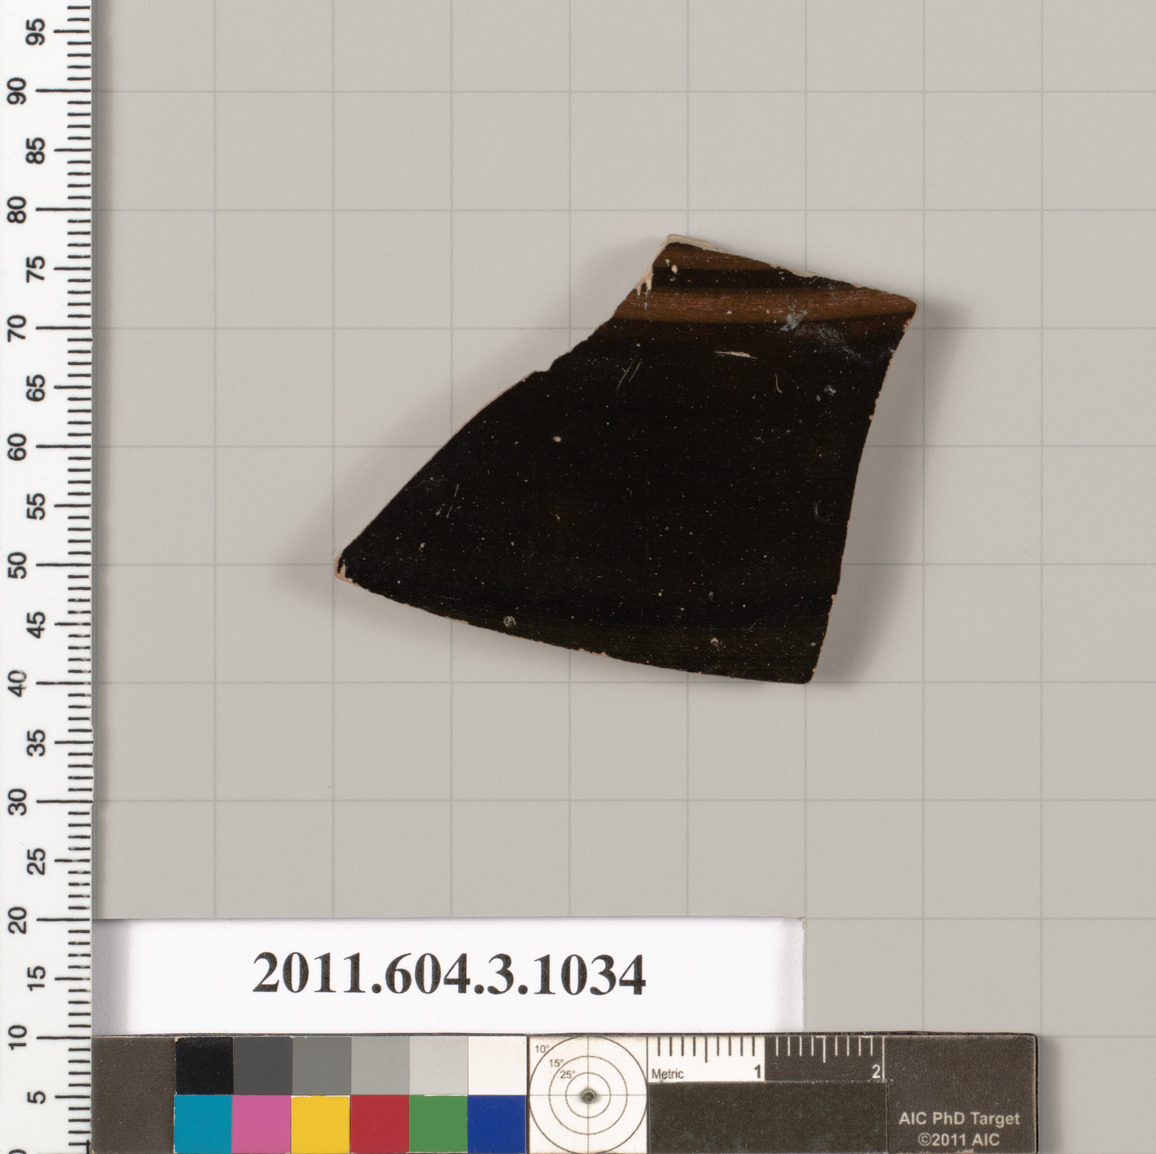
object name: lekanis fragment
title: Terracotta fragment of a lekanis (covered dish)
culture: greek, attic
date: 600-501 BCE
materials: terracotta